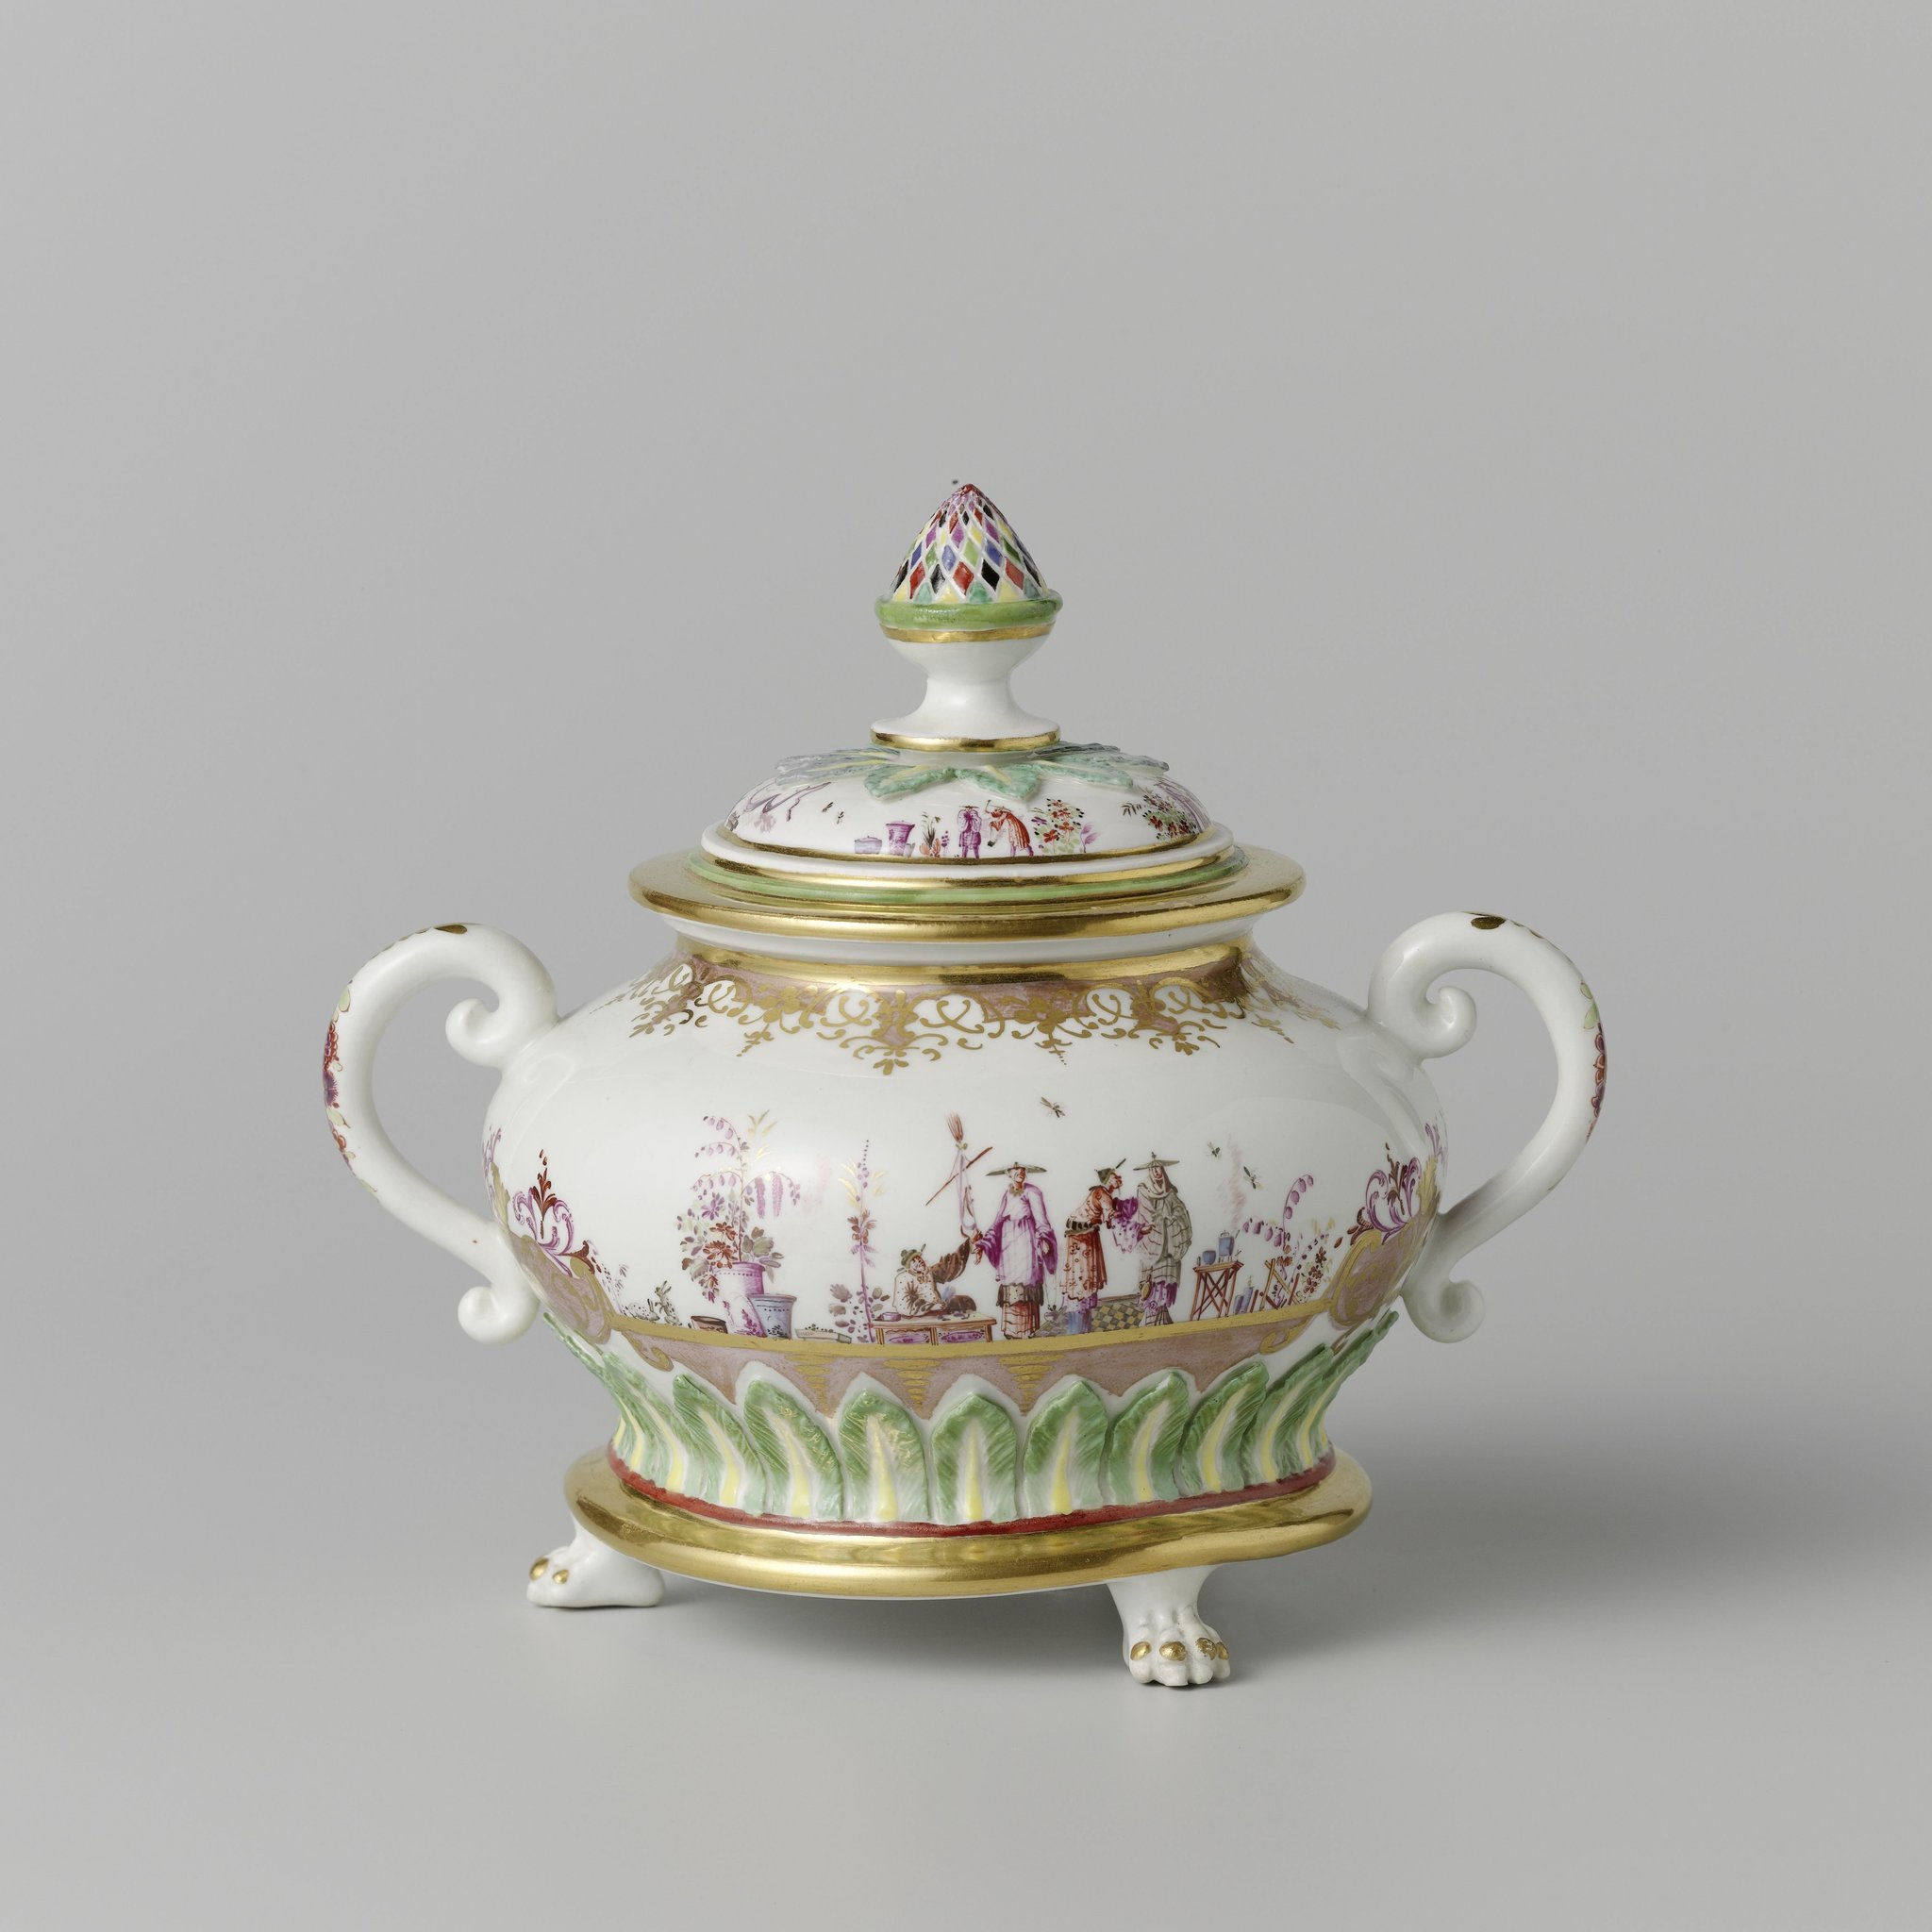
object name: sugar box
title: Sugar bowl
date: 1725-1730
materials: porcelain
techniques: painted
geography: meissen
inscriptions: number: ‘281.’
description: Meissener Porzellan Manufaktur Meissen, c. 1725–1730 hard-paste porcelain